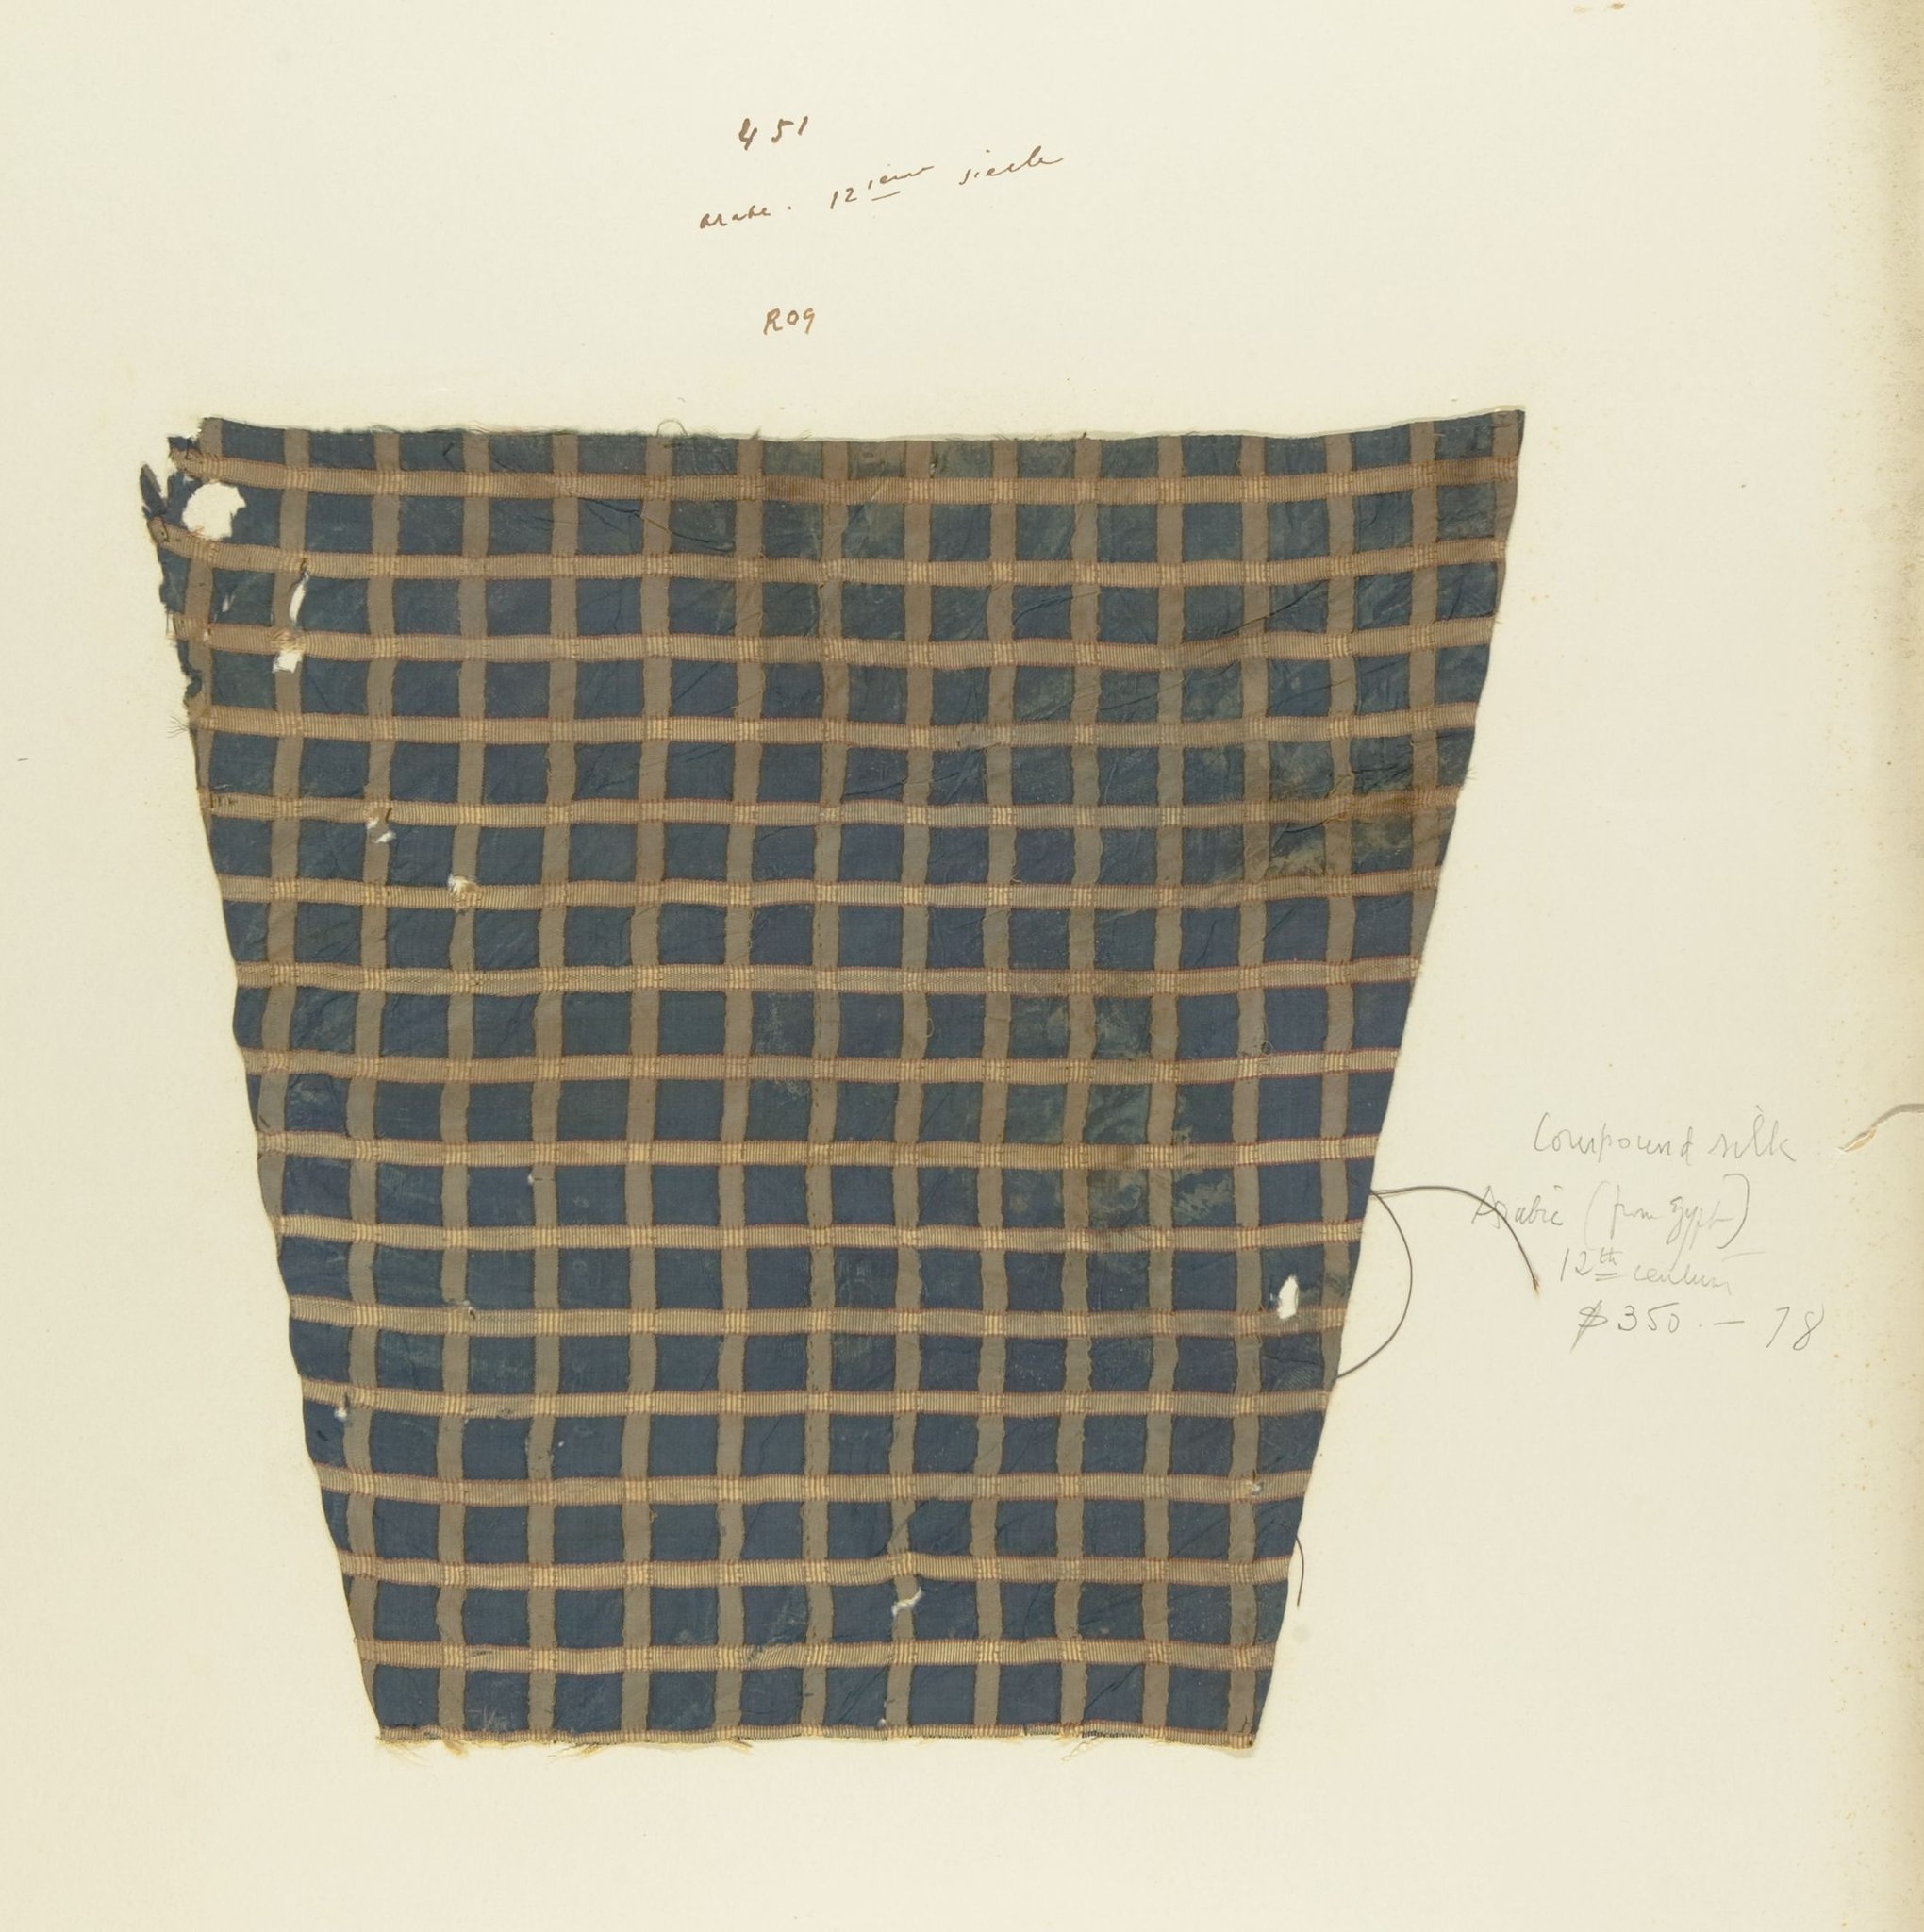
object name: textile fragment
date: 1101-1200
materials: cotton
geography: egypt